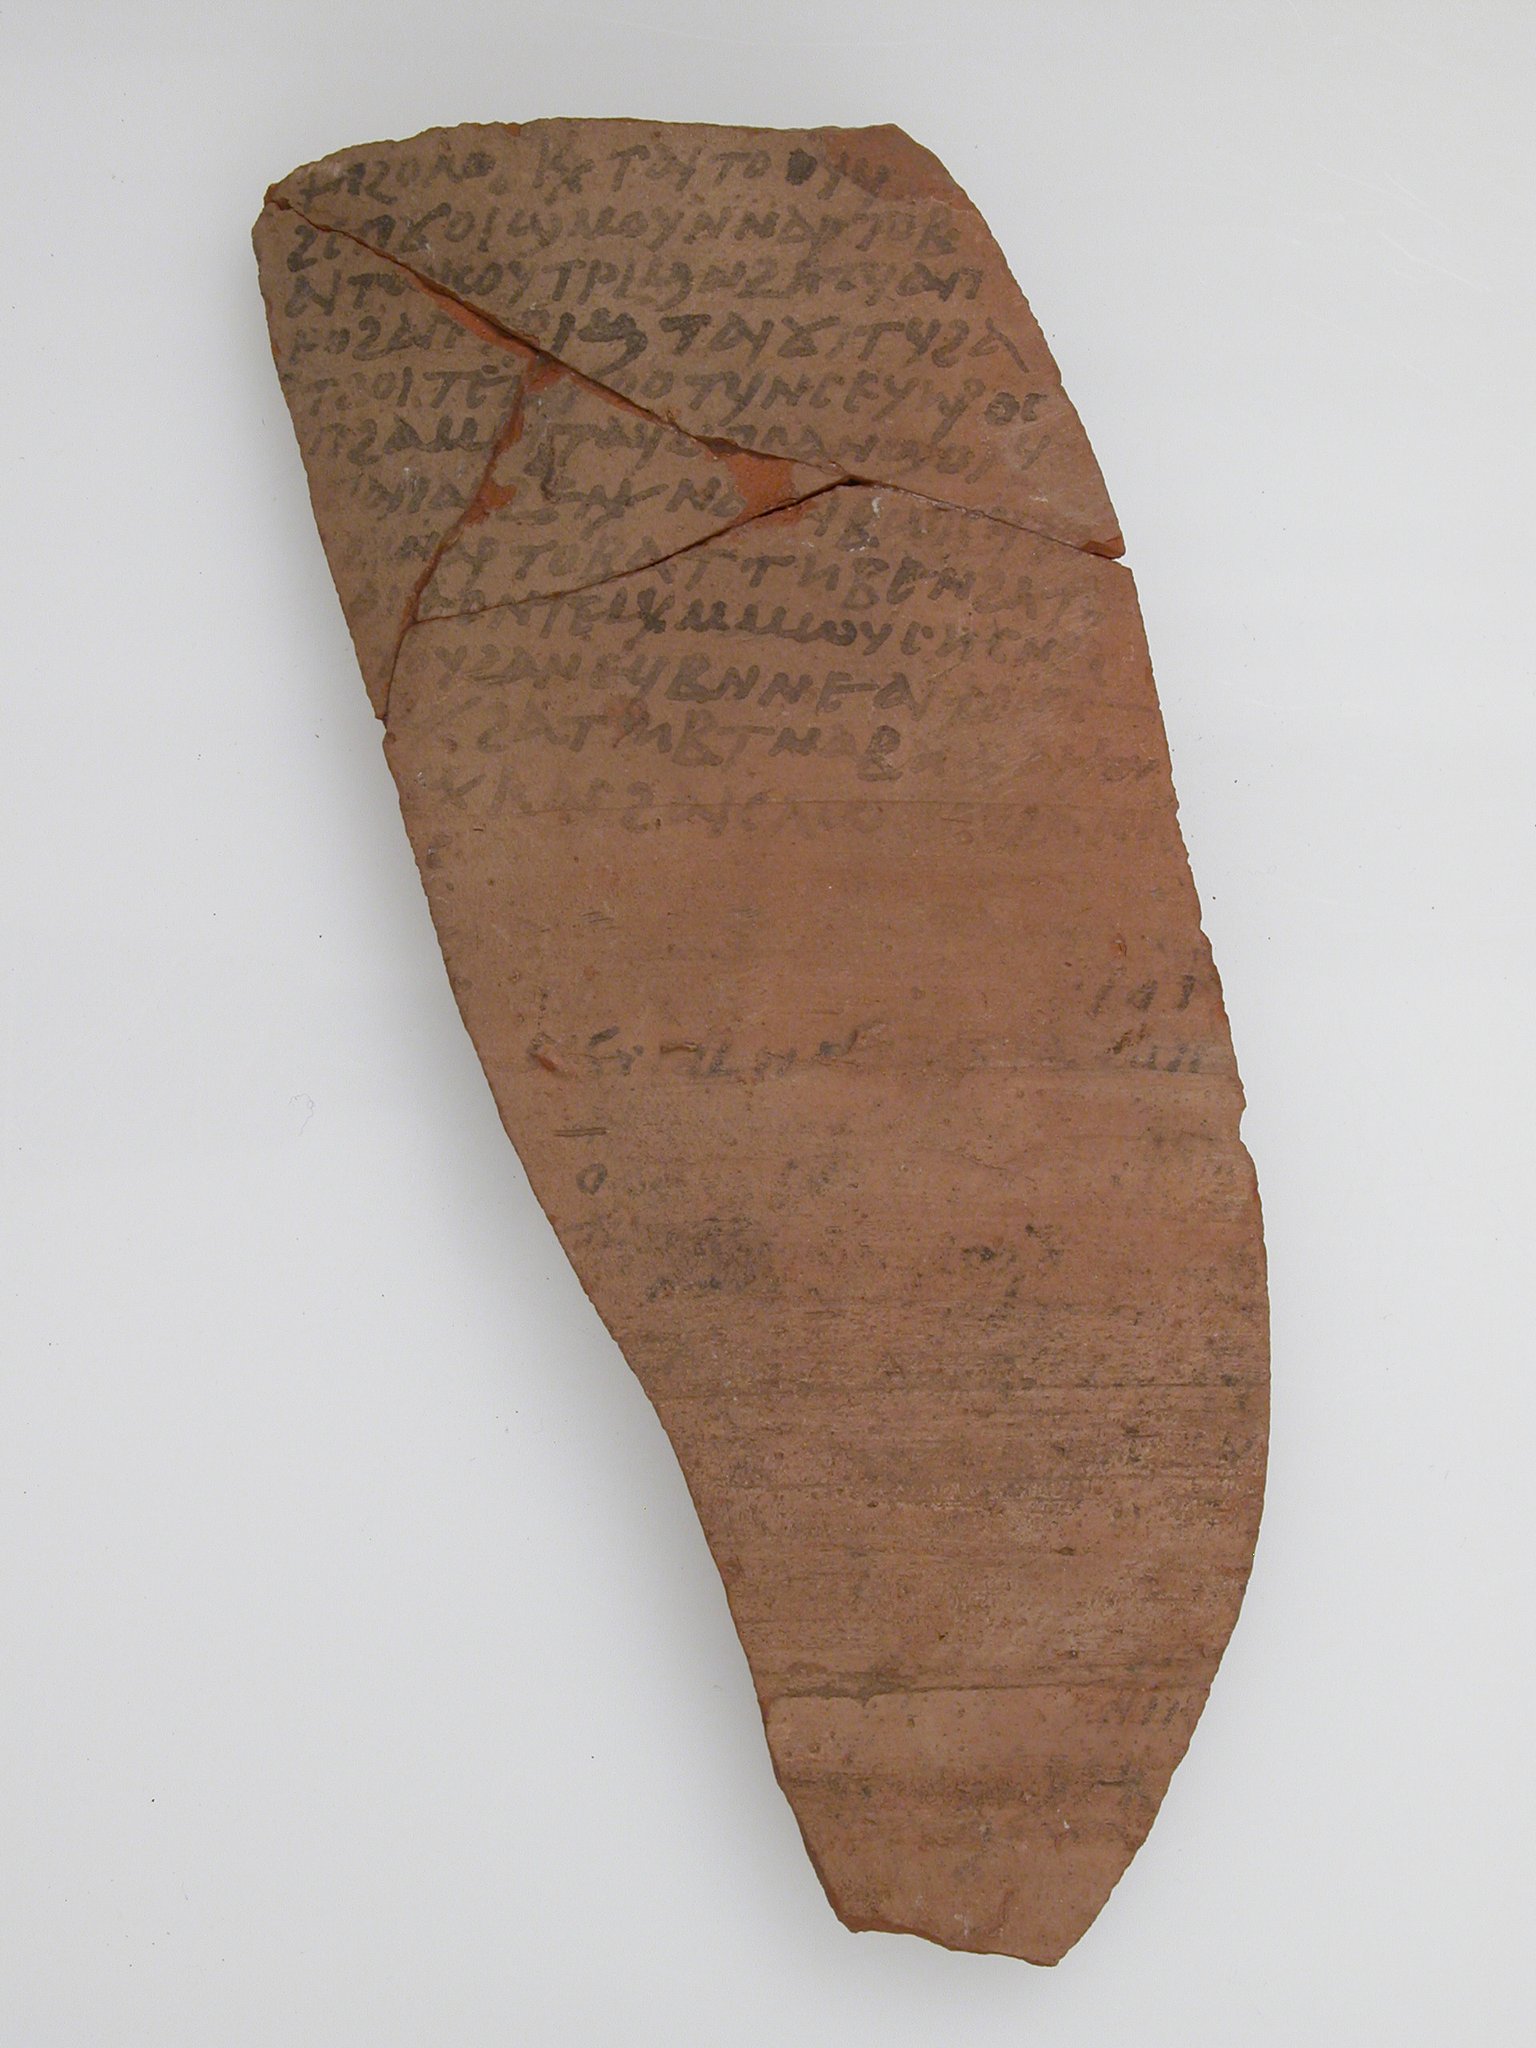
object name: ostrakon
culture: coptic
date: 601-700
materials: ink, pottery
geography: egypt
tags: documents